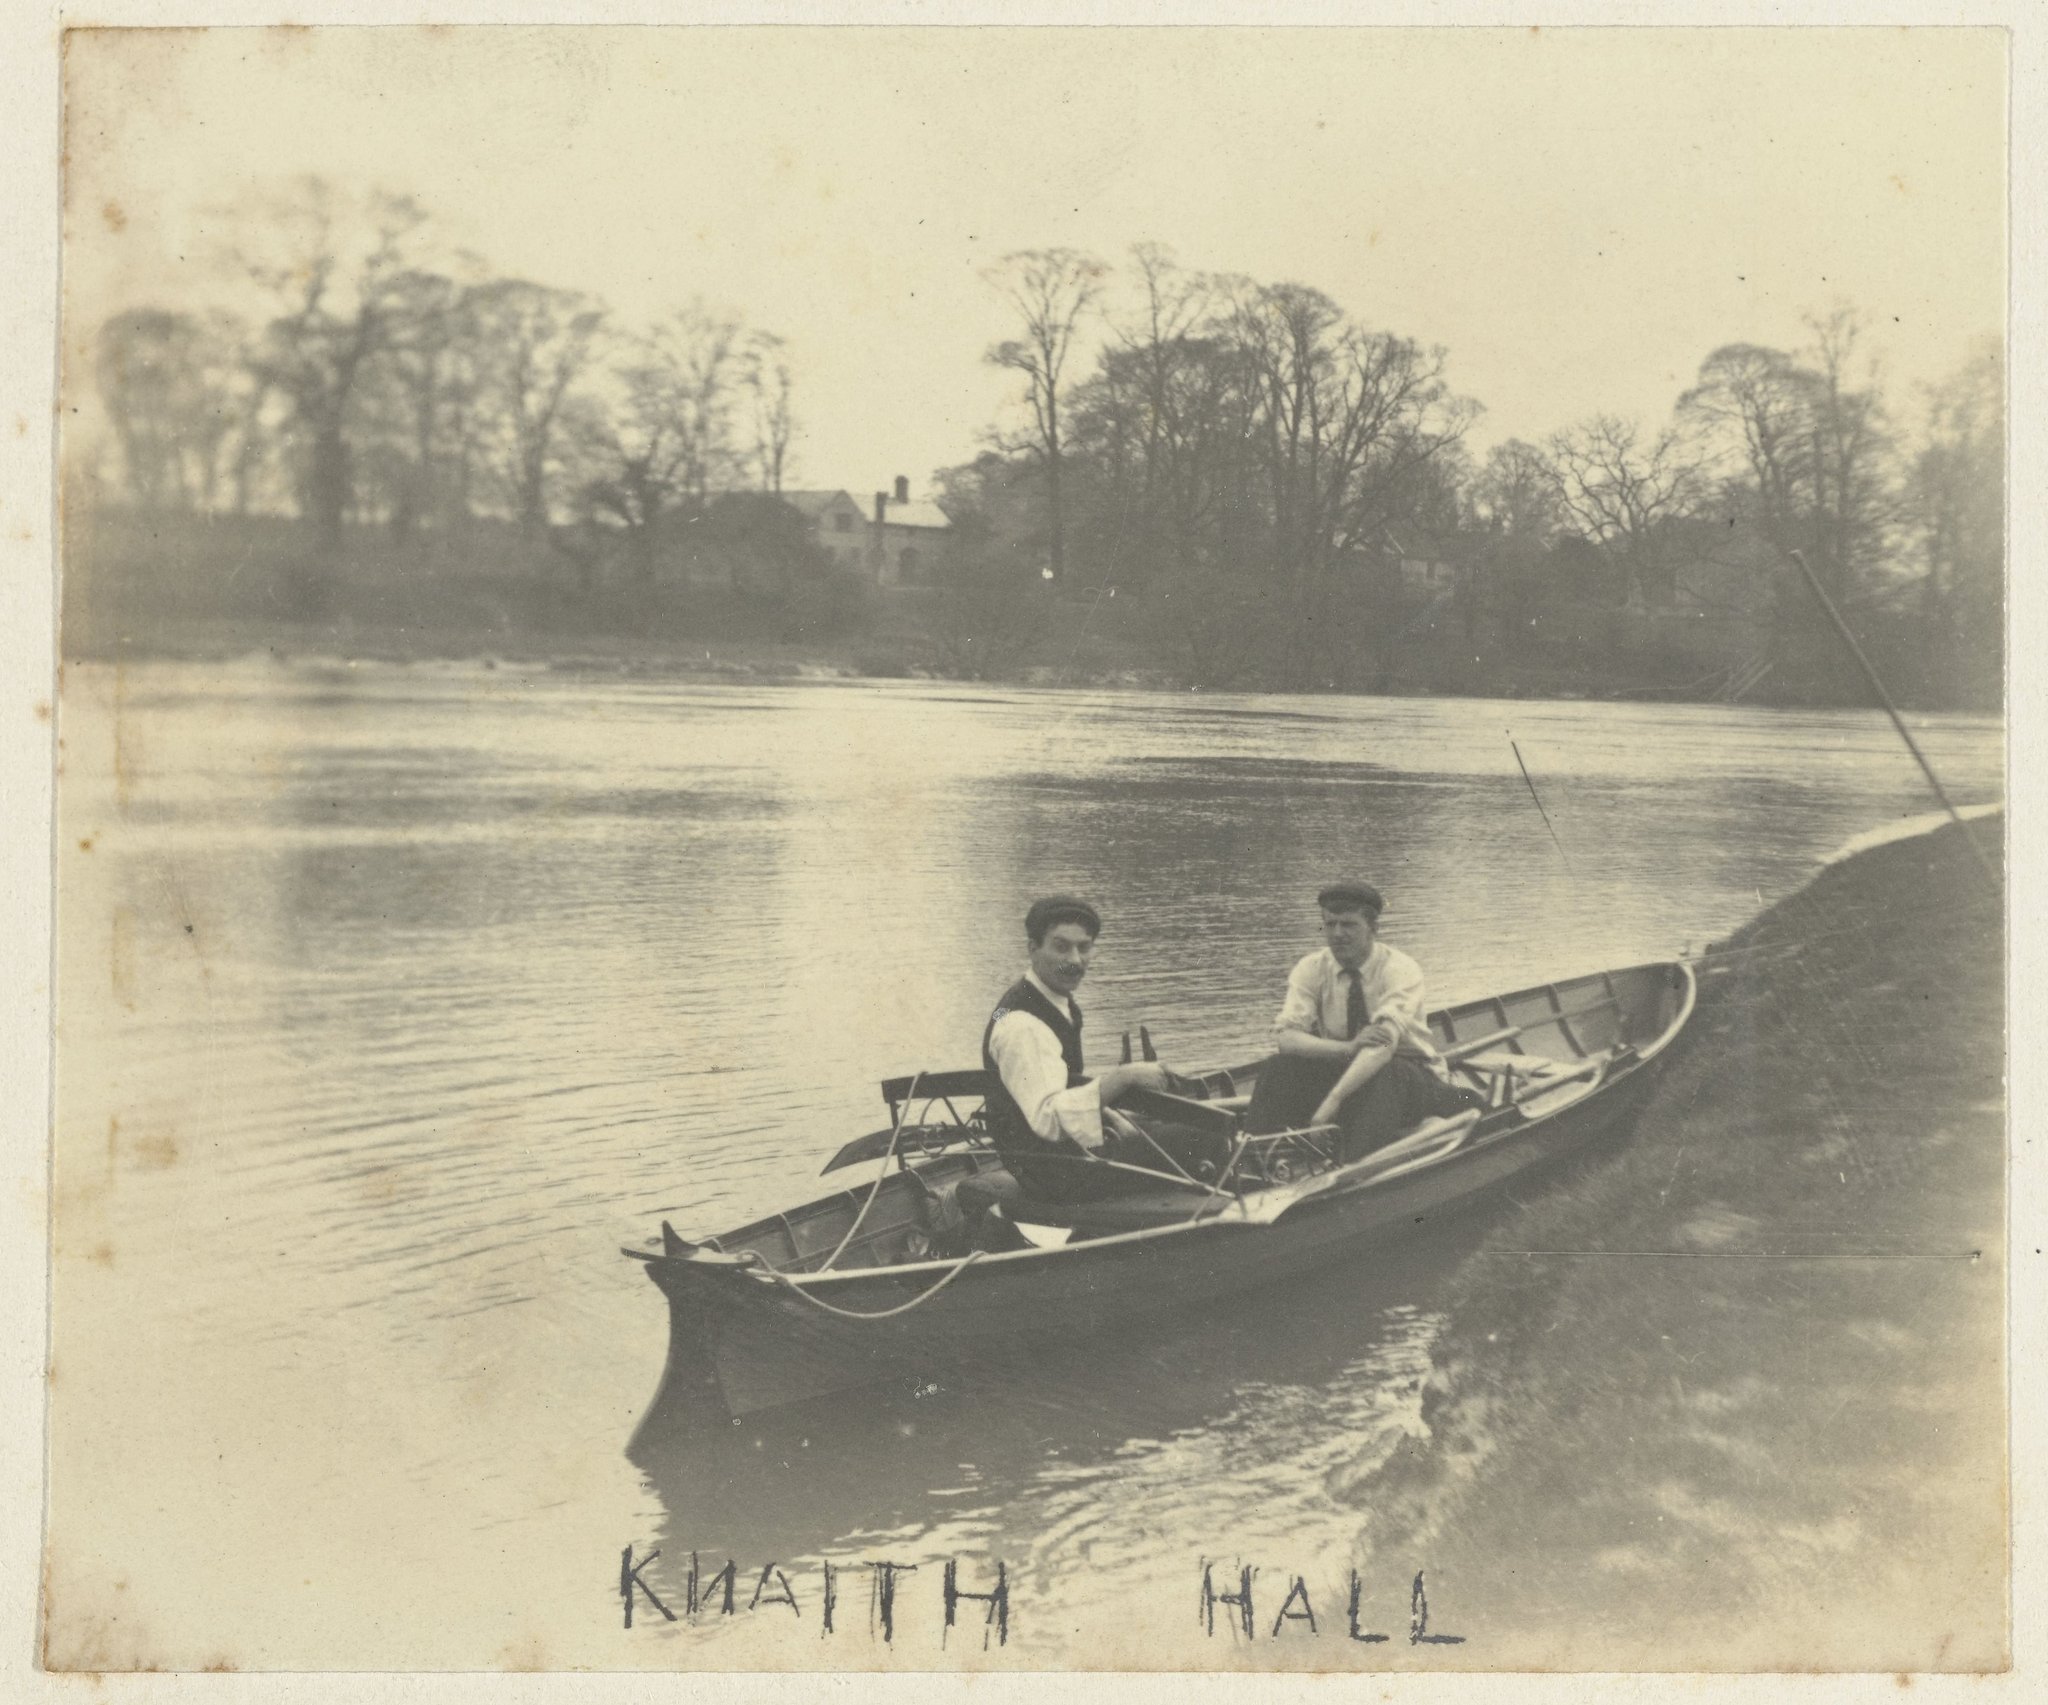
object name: photograph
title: Knaith Hall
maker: geldolph adriaan kessler (dolph)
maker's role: fotograaf, industrieel, voetballer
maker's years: 1884-1945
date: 1903-1904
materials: cardboard, photographic support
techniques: gelatin silver print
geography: gainsborough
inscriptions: title: ‘Knaith Hall’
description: Twee vrienden van Dolph Kessler in een roeiboot in Knaith Hall bij Gainsborough. Onderdeel van het fotoalbum van Dolph Kessler met opnamen die hij maakte tijdens zijn verblijf in Engeland en op een wereldreis die hij als secretaris van Henri Deterding (directeur Koninklijke Olie) ondernam naar Nederlands-Indië, Japan, China en de Verenigde Staten, tussen 1906 en 1908.